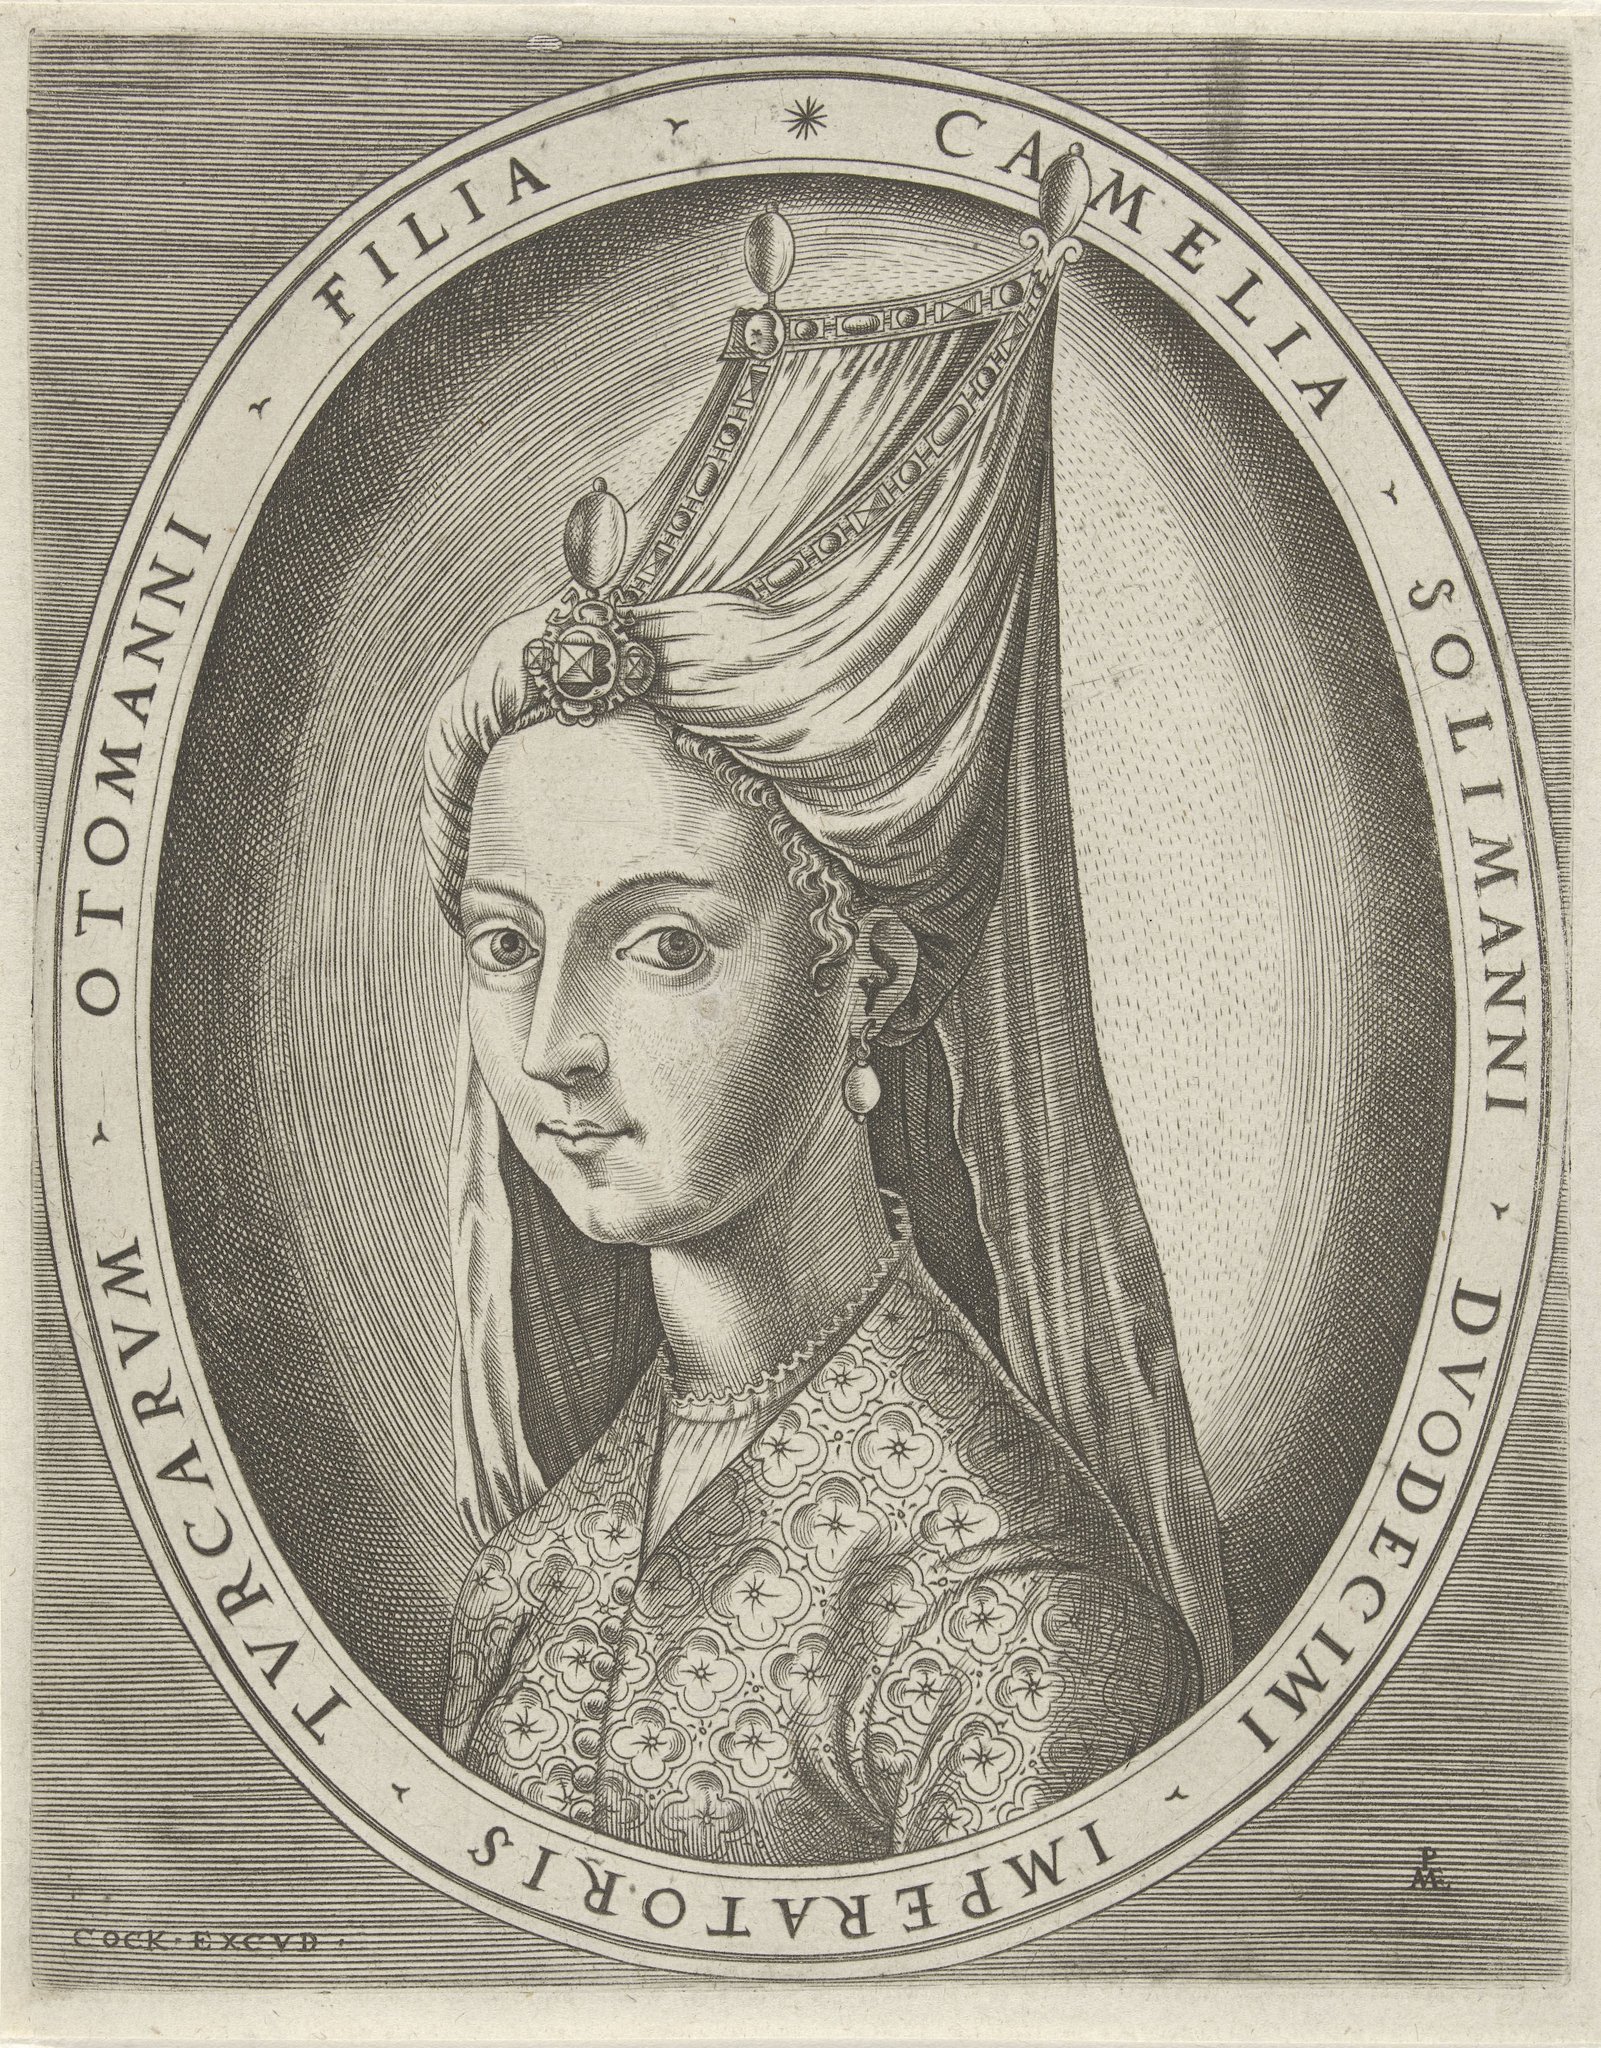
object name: print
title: Portret van Camalia, dochter van Suleyman I de Grote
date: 1540-1570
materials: paper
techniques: engraving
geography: antwerp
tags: veil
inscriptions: collector's mark: Lugt 2228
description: Buste naar links van Camalia, dochter van Suleyman I de Grote in een ovaal met haar naam en titel in het Latijn.